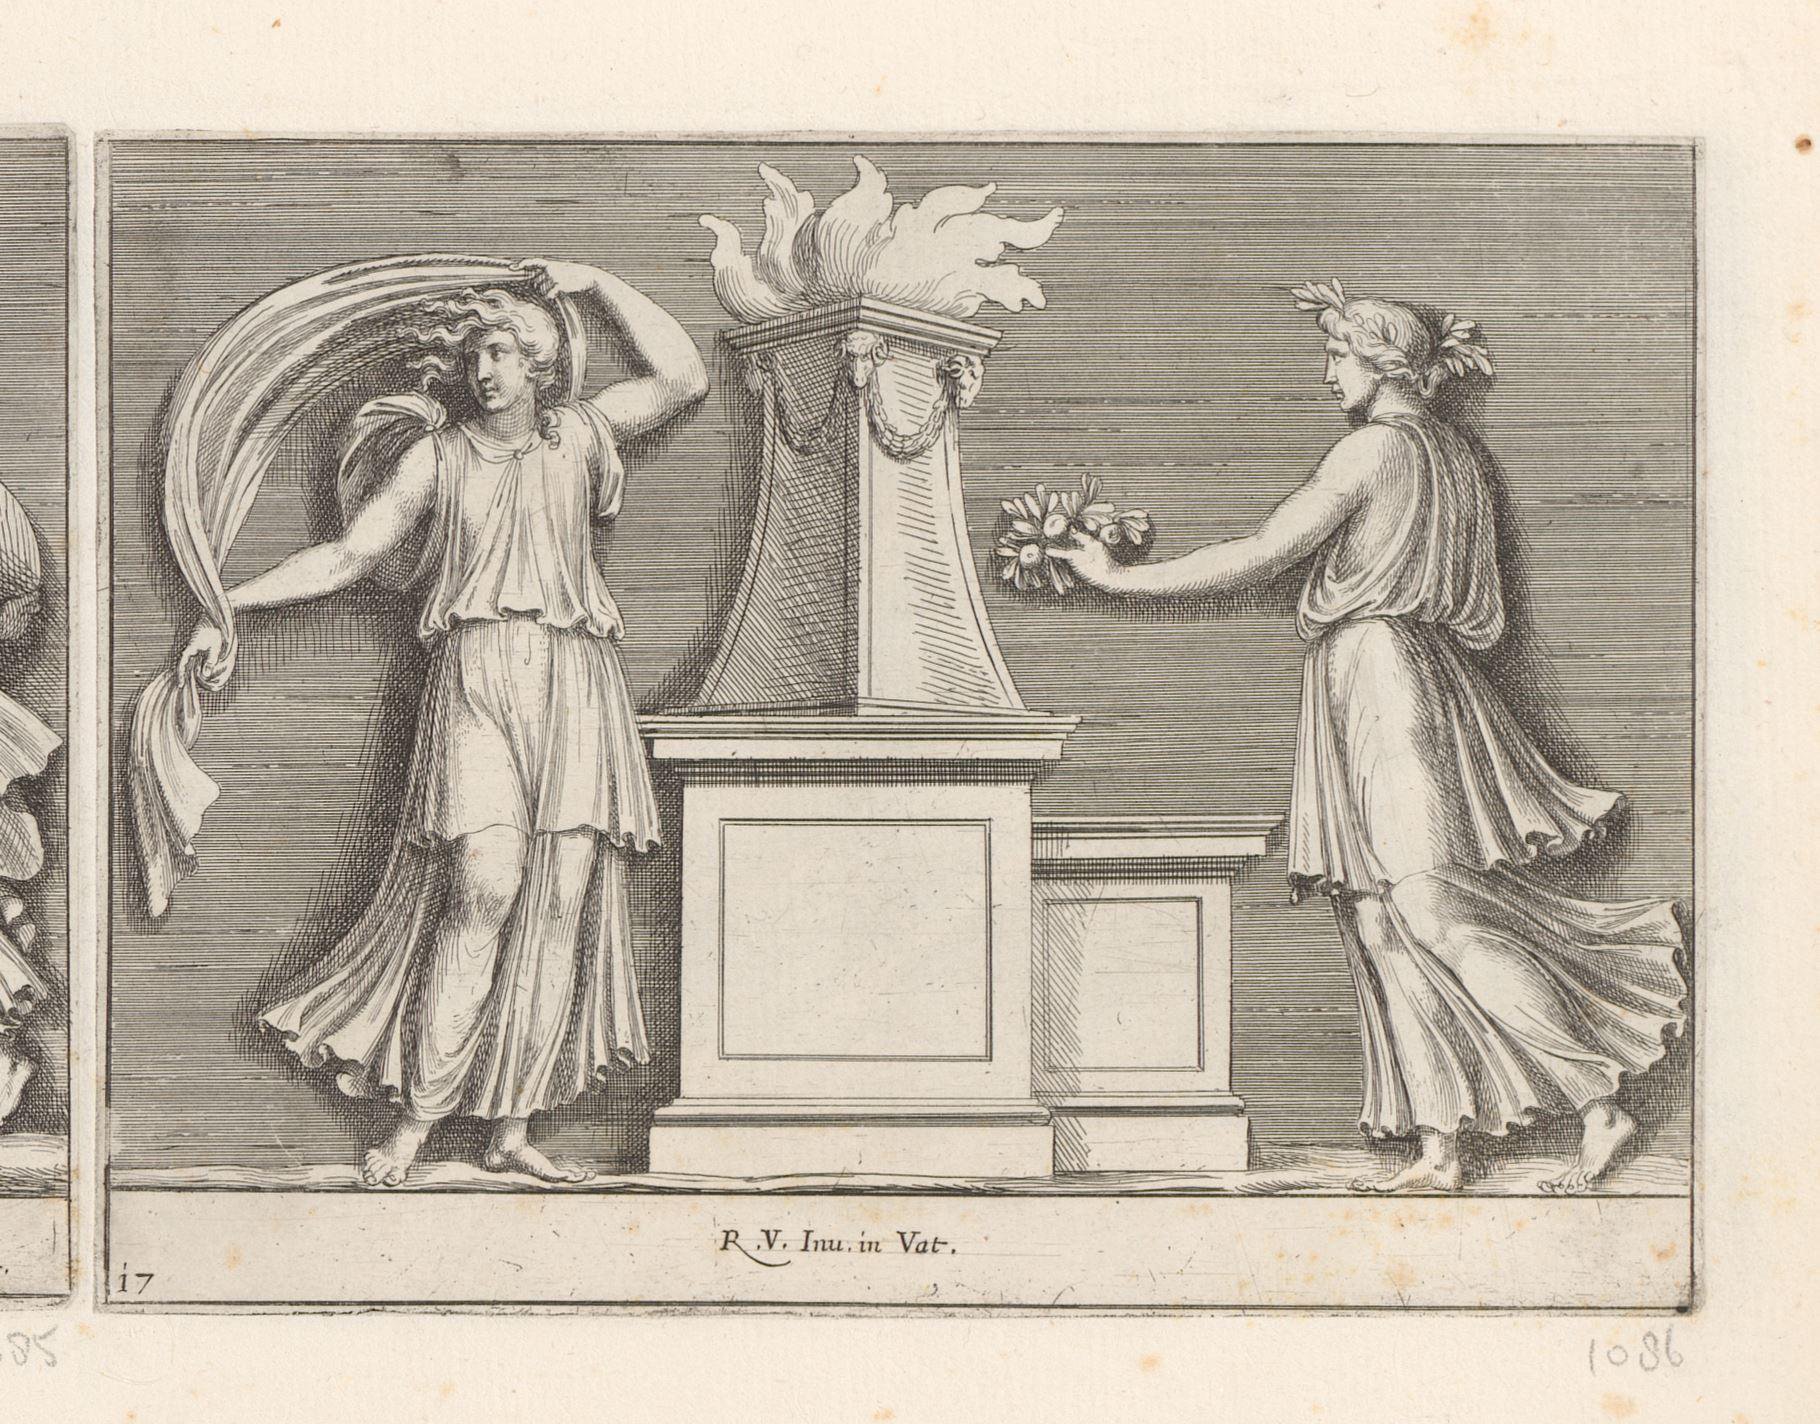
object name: print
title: Reliëfs in de Loggia van Rafaël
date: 1645-1700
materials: paper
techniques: engraving, etching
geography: italy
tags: adult woman, sacrifice ~ roman religion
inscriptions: number: ‘44’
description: Prent uit een reeks naar de gipsen reliëfs door Rafaël en uitgevoerd door zijn assistenten in de Vaticaanse Loggia.